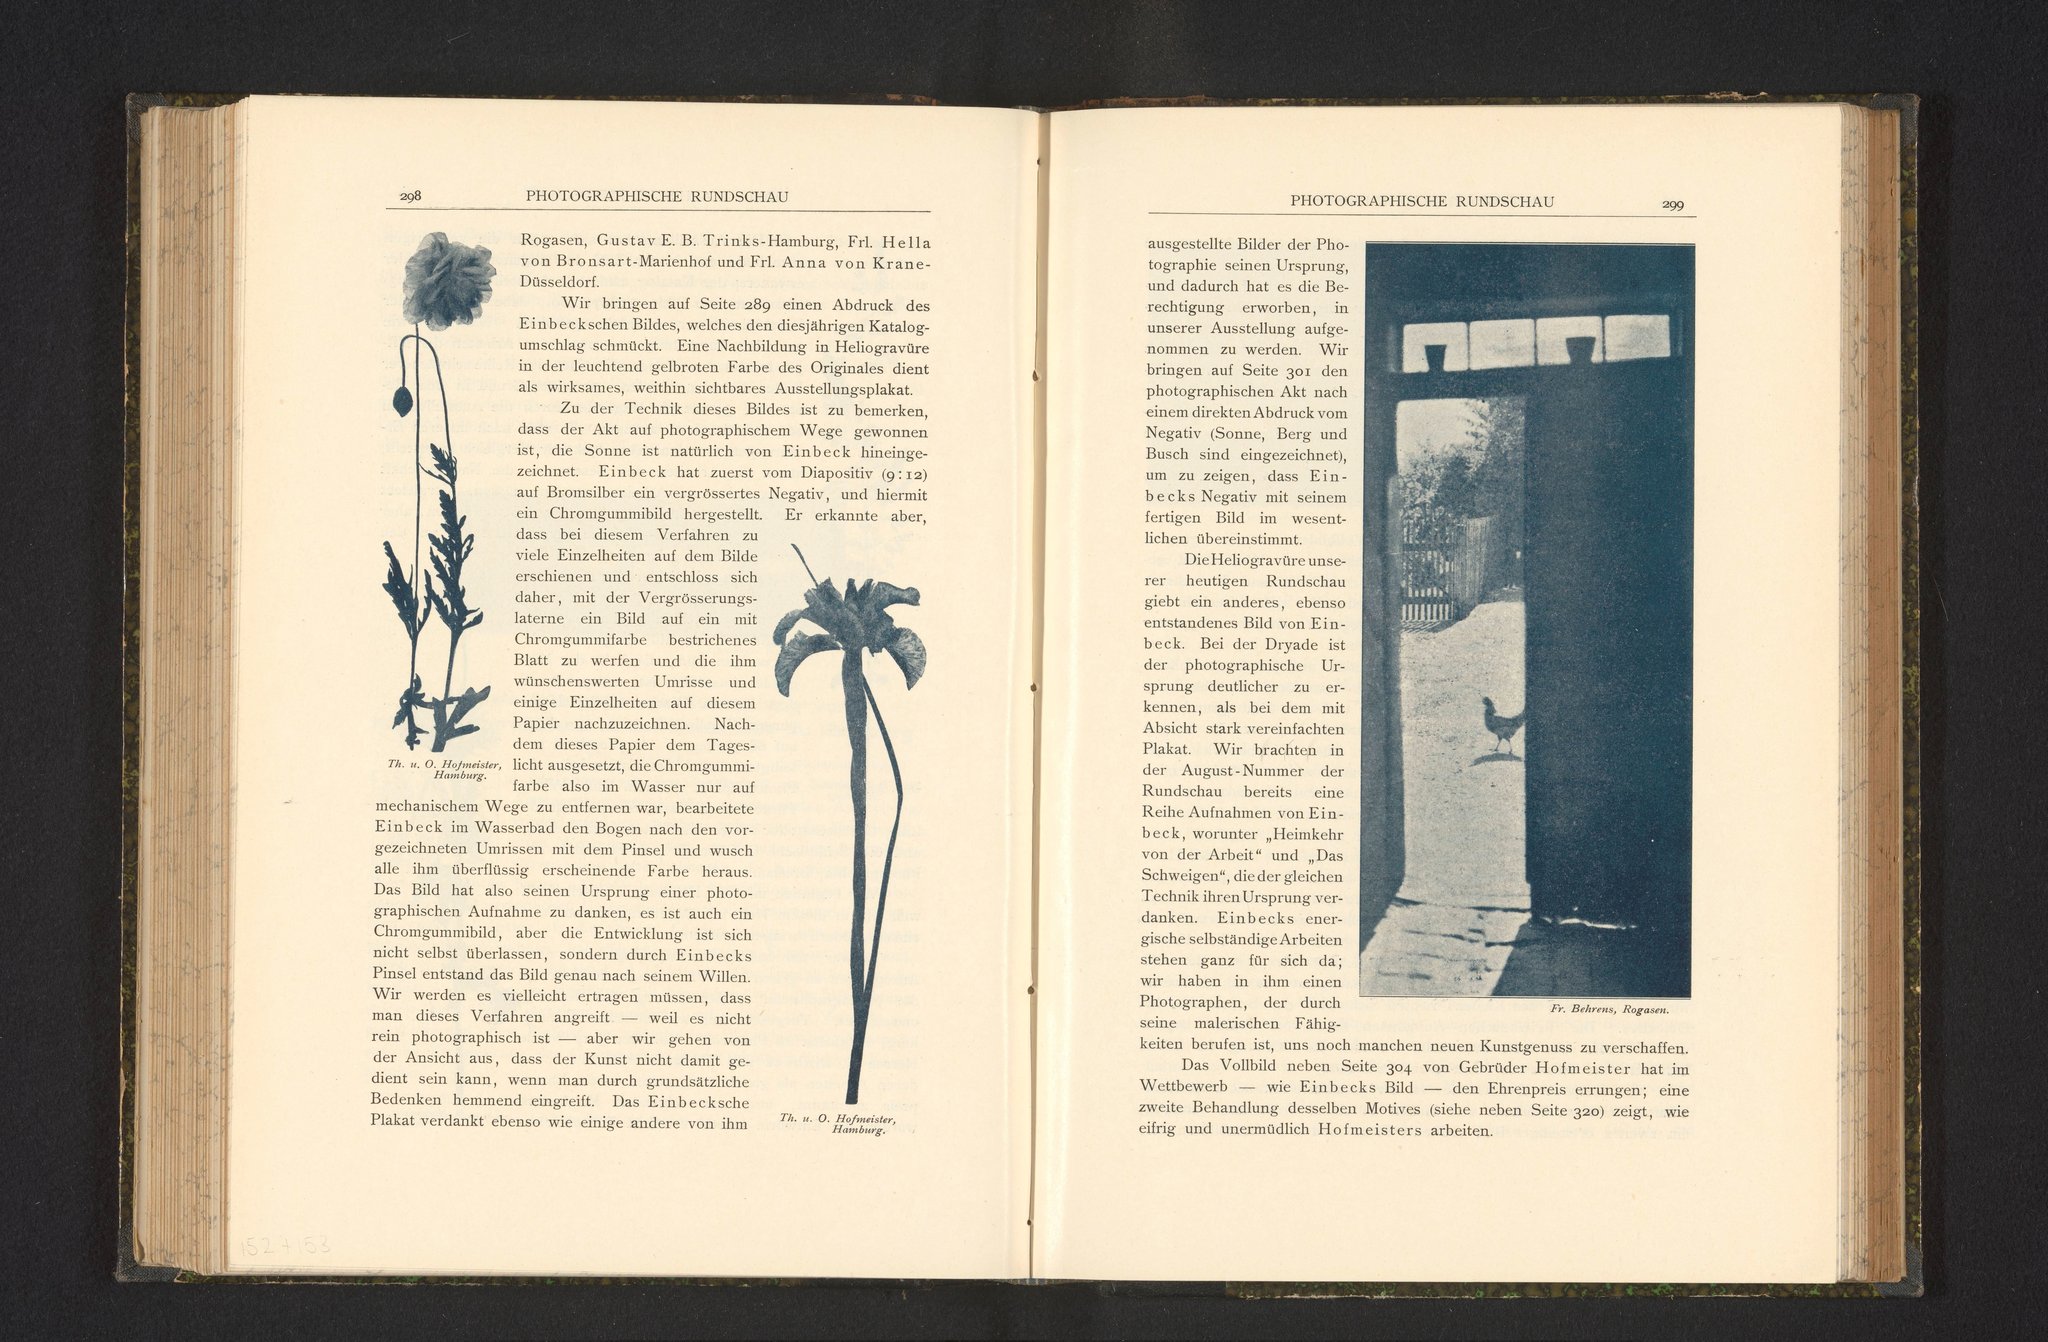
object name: page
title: Plant met bloem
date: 1893-1898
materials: paper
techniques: autotype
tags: plants (in general), flowers